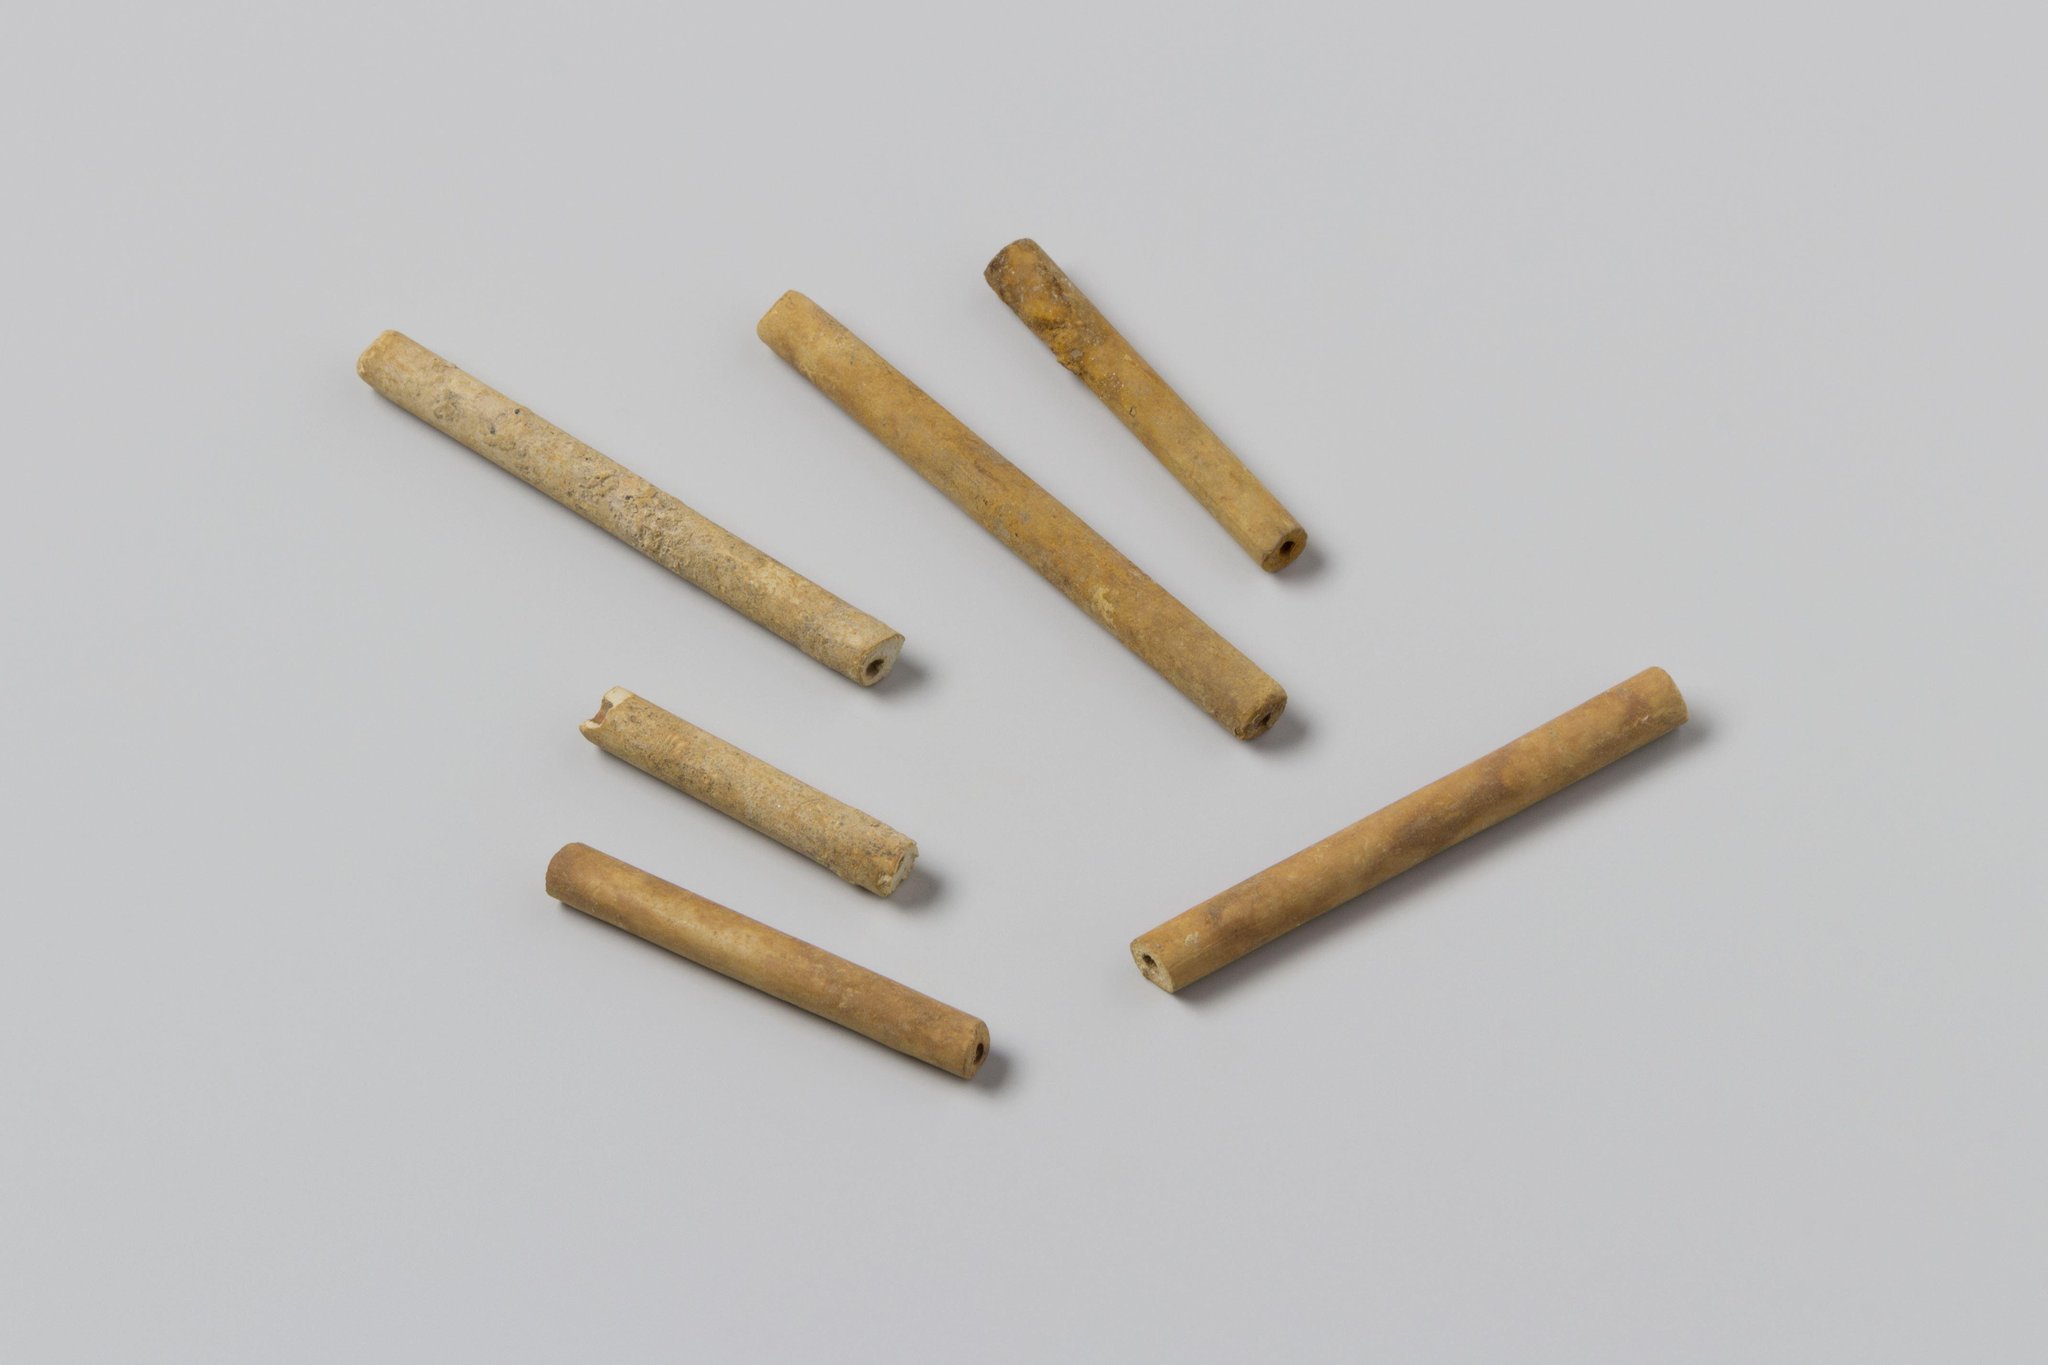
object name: pipe stem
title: Fragmenten pijpenstelen uit het wrak van de Oost-Indiëvaarder Hollandia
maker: Anonymous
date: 1700-1743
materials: clay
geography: netherlands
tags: verenigde oostindische compagnie, hollandia (schip), annet